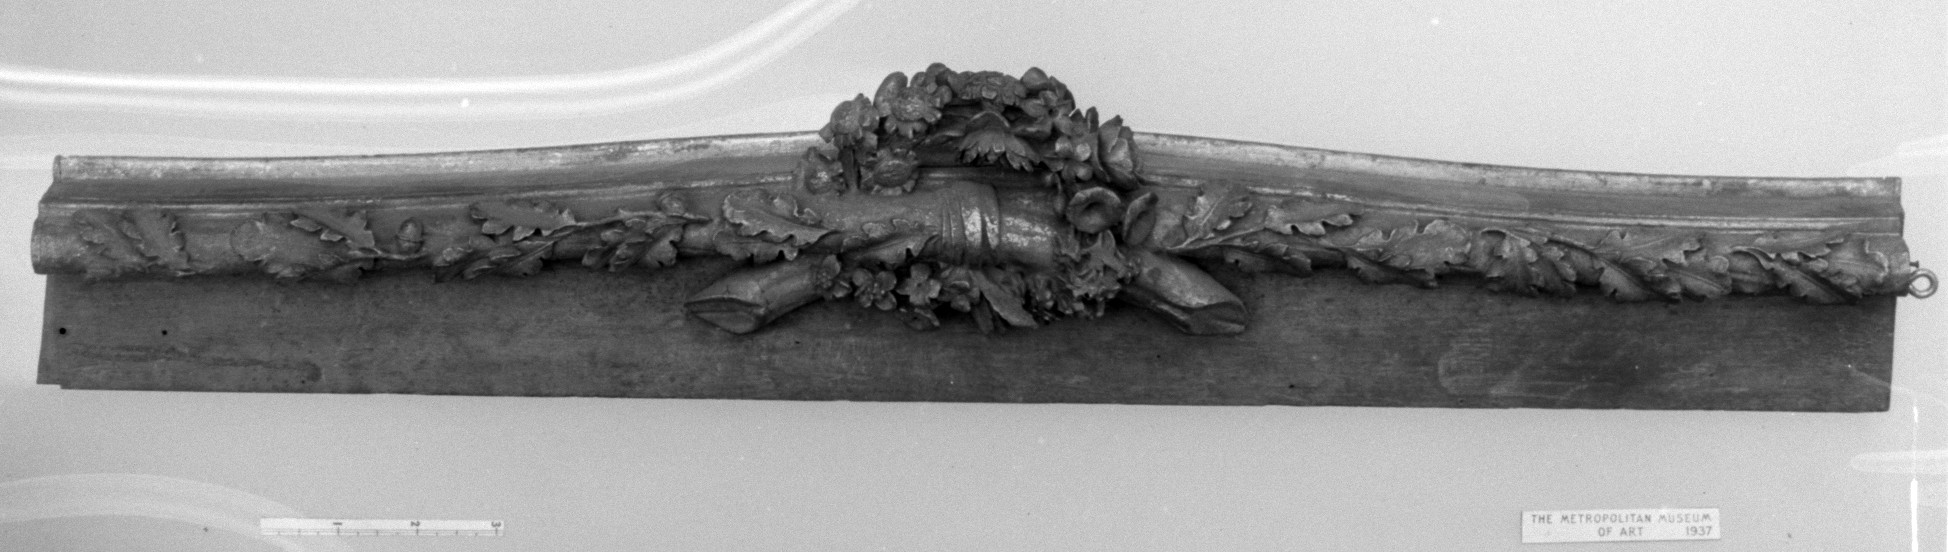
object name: fragment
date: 1701-1800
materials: wood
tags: flowers,leaves